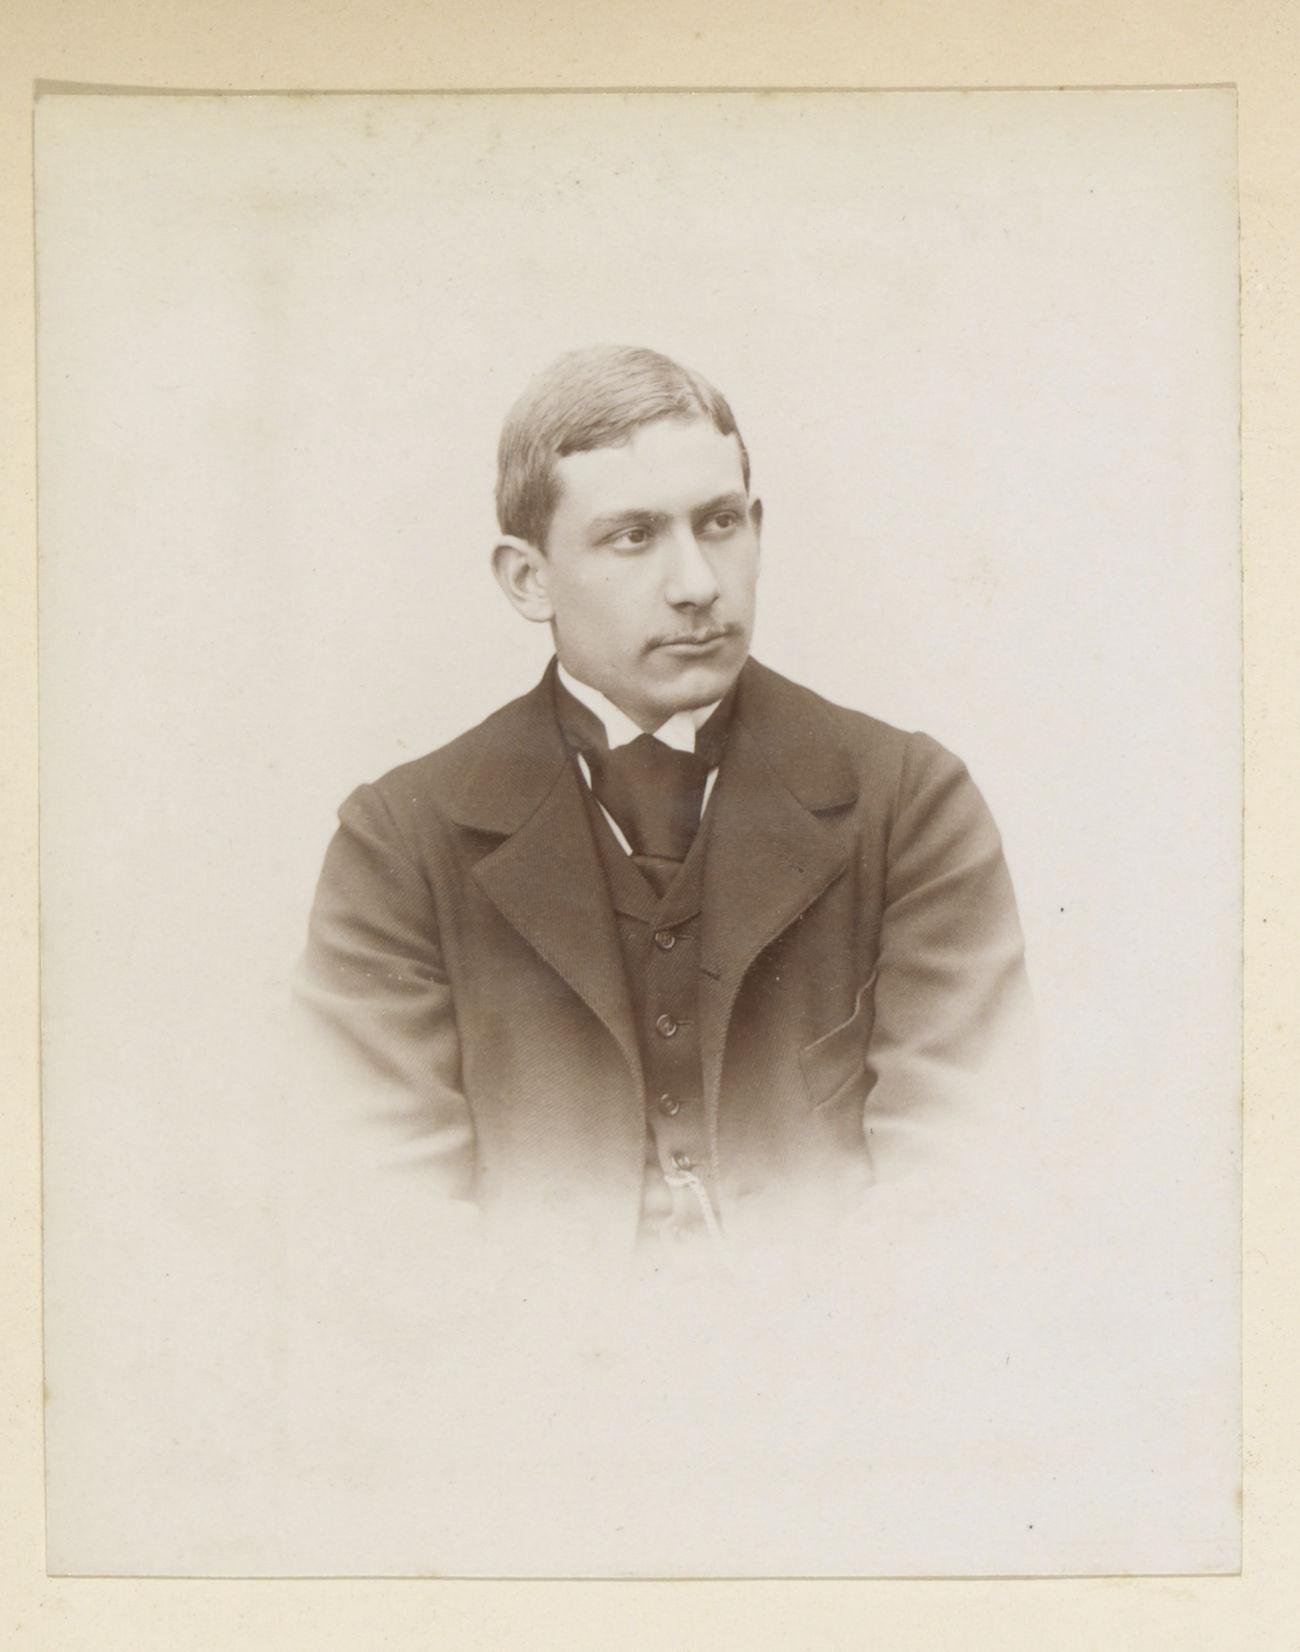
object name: photograph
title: Portret van een Franse man met een das en een snor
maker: Anonymous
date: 1900-1910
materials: paper, photographic support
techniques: daylight paper print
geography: france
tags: moustache, adult man, neck-gear ~ clothing, france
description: Onderdeel van Fotoalbum van een Franse amateurfotograaf met opnames van een familie, distilleerderij Delizy & Doistau Fils, het leger en bezienswaardigheden in Frankrijk.